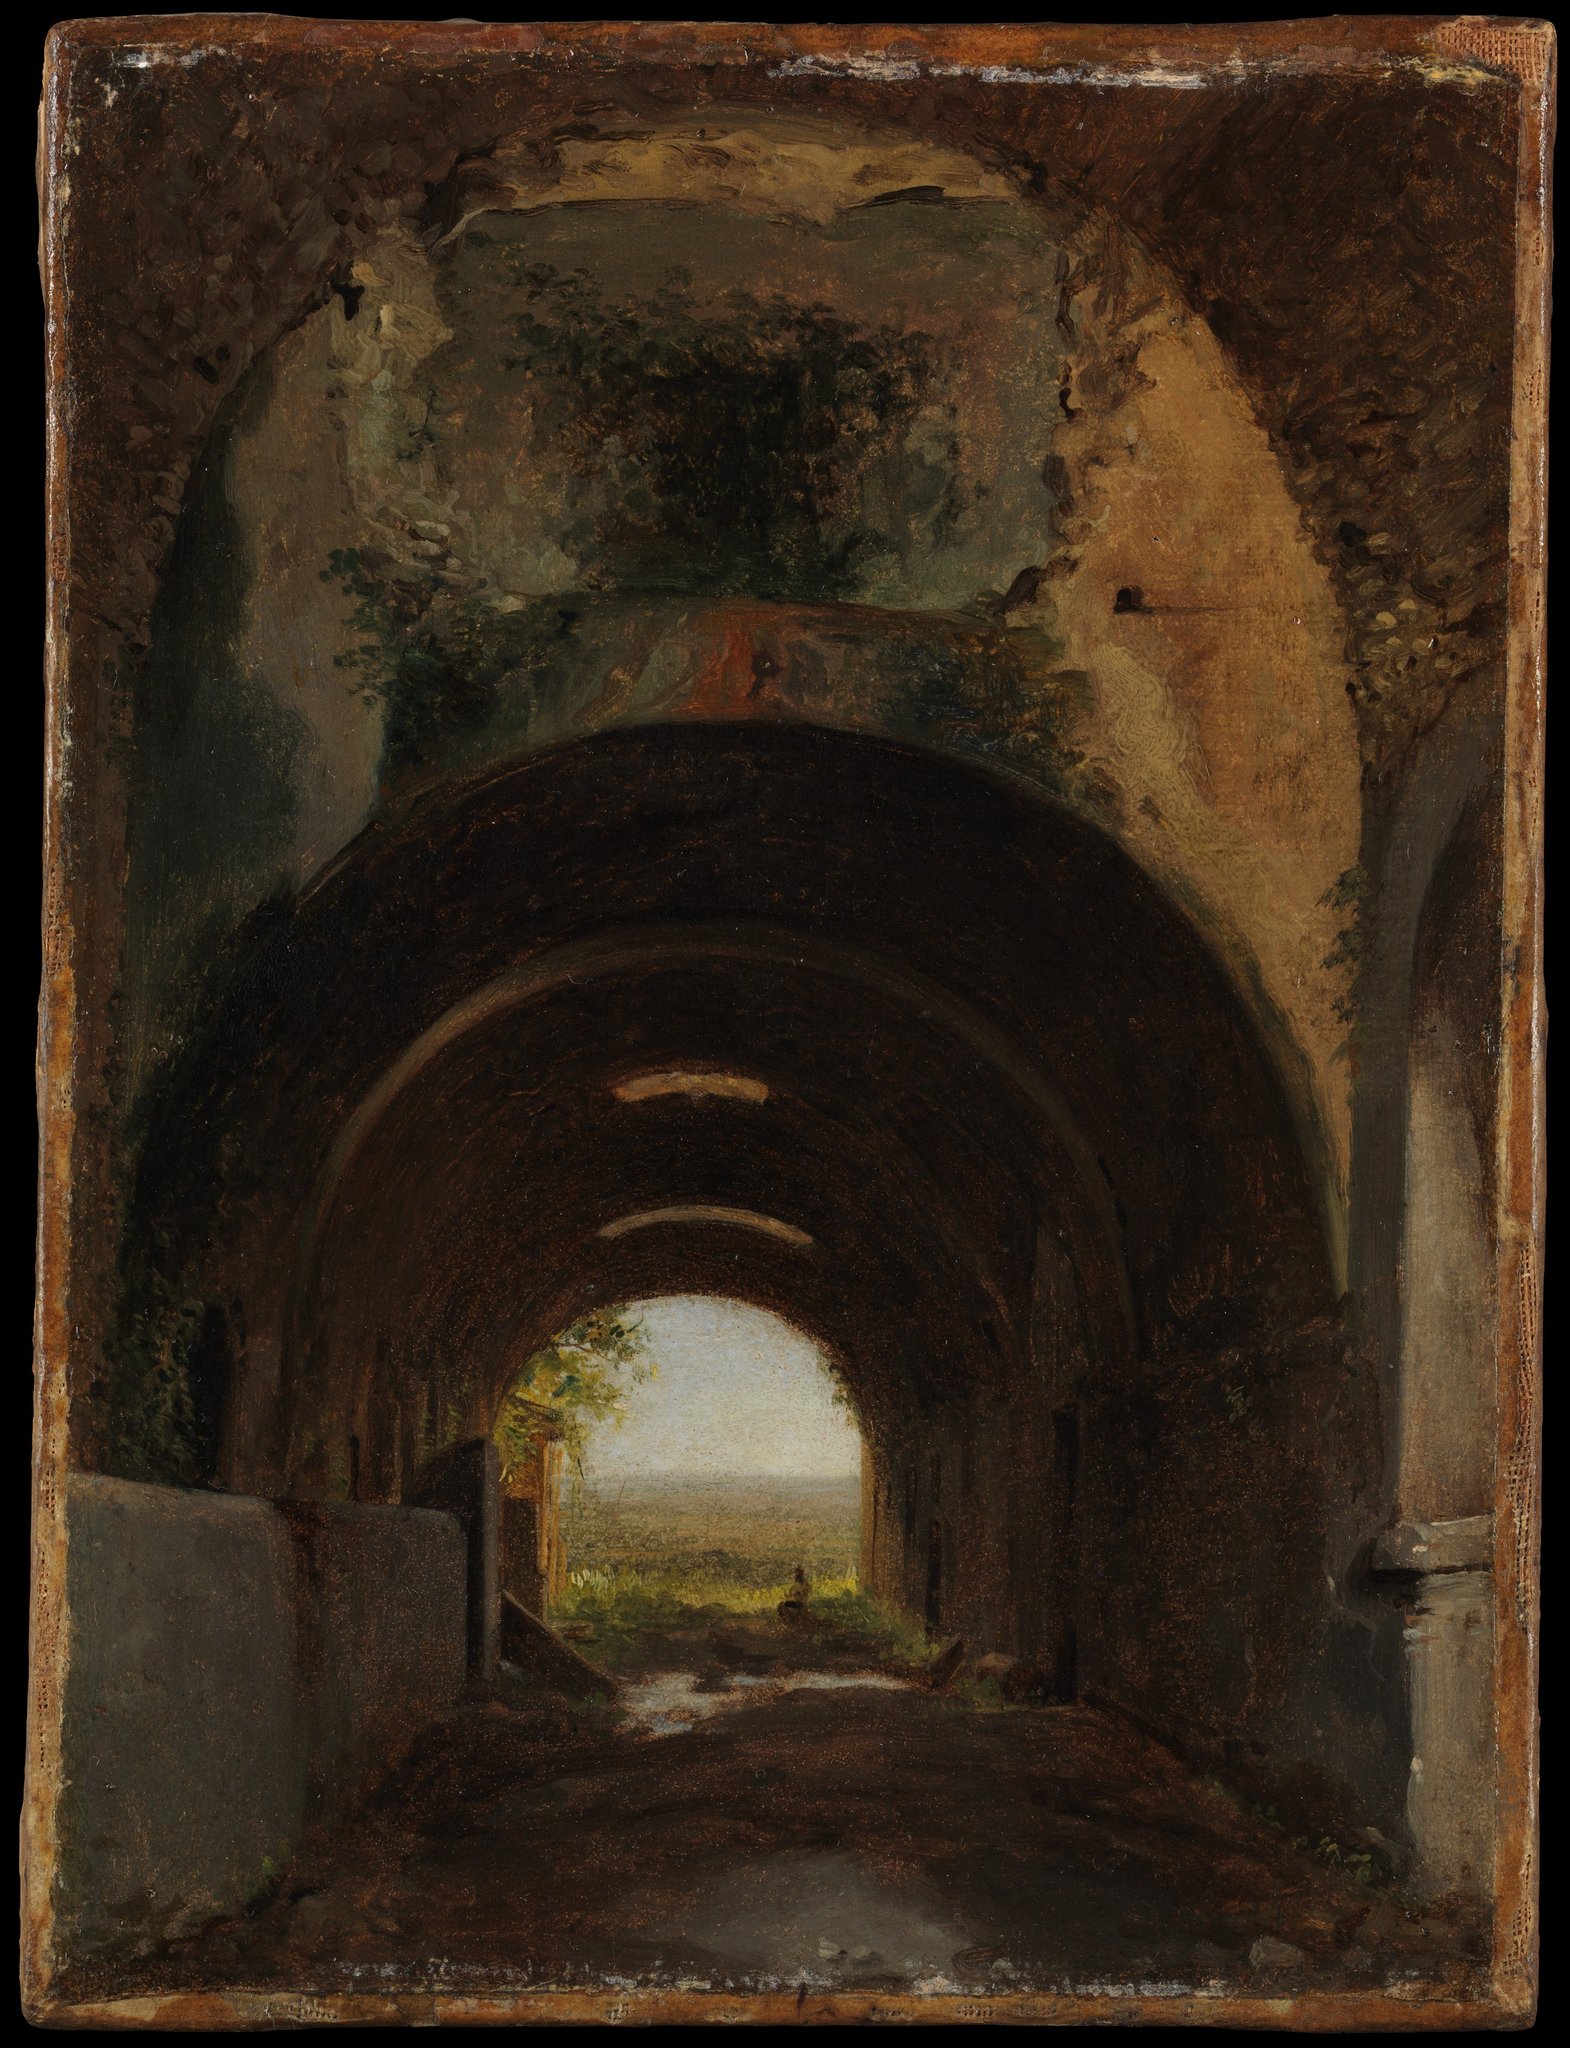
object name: painting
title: View in the Stables of the Villa of Maecenas, Tivoli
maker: françois marius granet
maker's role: artist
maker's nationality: french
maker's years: 1775-1849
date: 1805-1810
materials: canvas, oil, paper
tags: arches